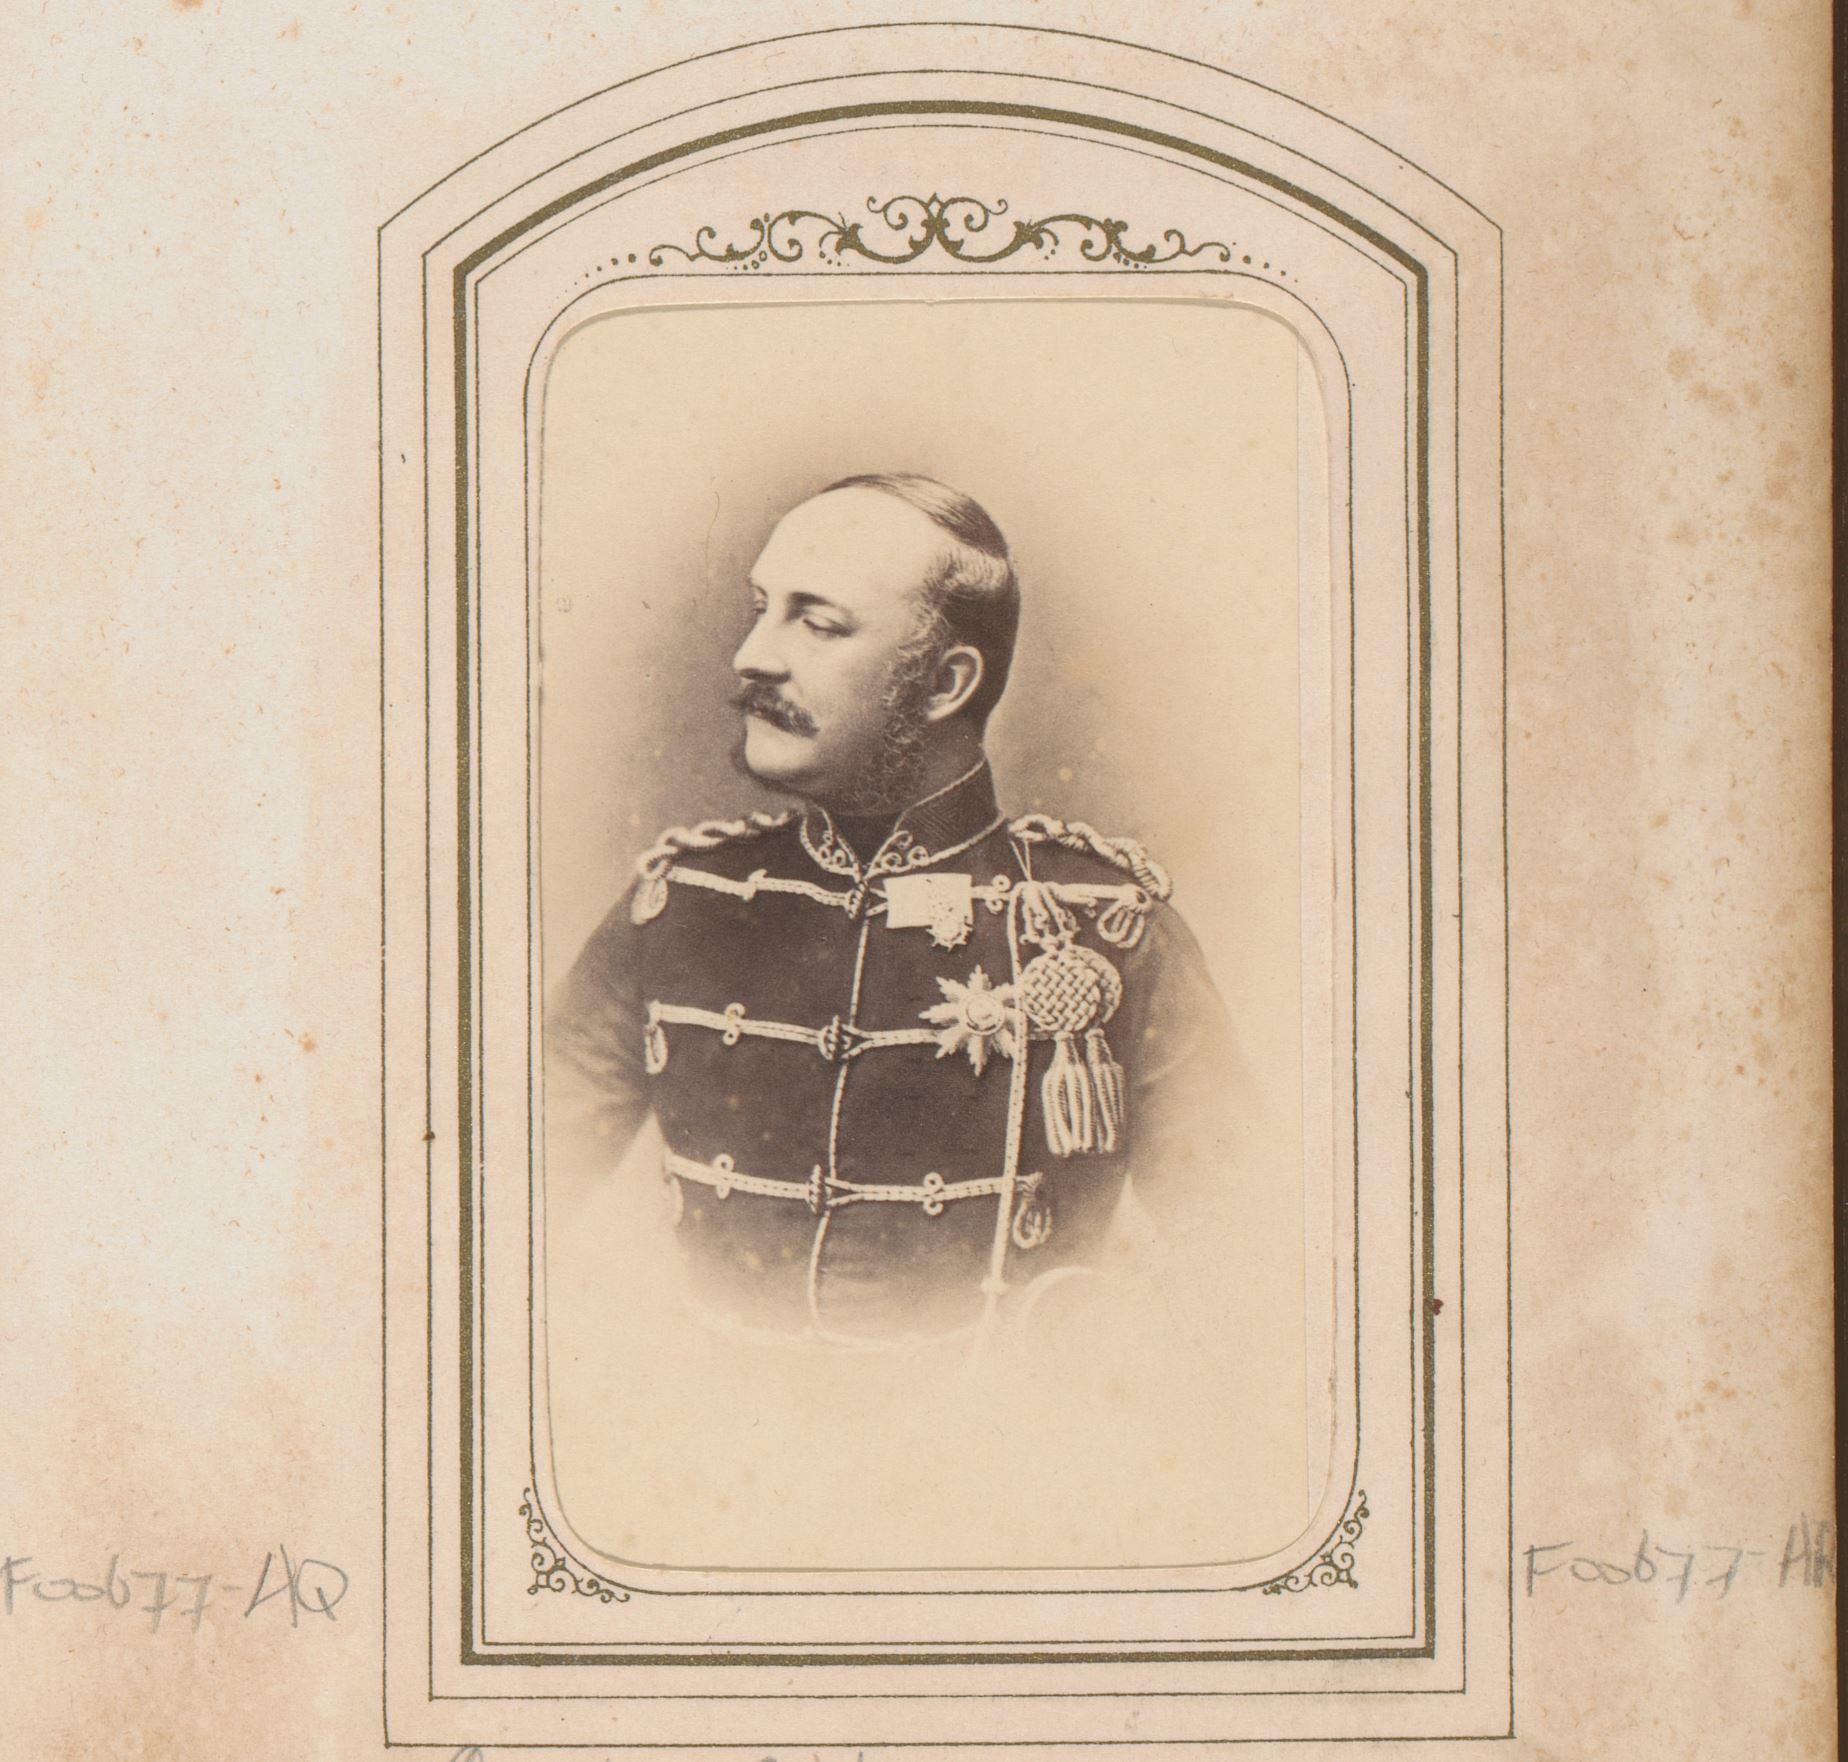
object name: carte de visite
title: Portret van George V, koning van Hannover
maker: albert goupil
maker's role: publisher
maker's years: 1840-1884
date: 1850-1866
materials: cardboard, photographic support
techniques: albumen print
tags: historical persons, king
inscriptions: annotation: ‘George V, koning van Hannover/ (1819-1878, koning tot 1866)’, annotation: ‘(...)’